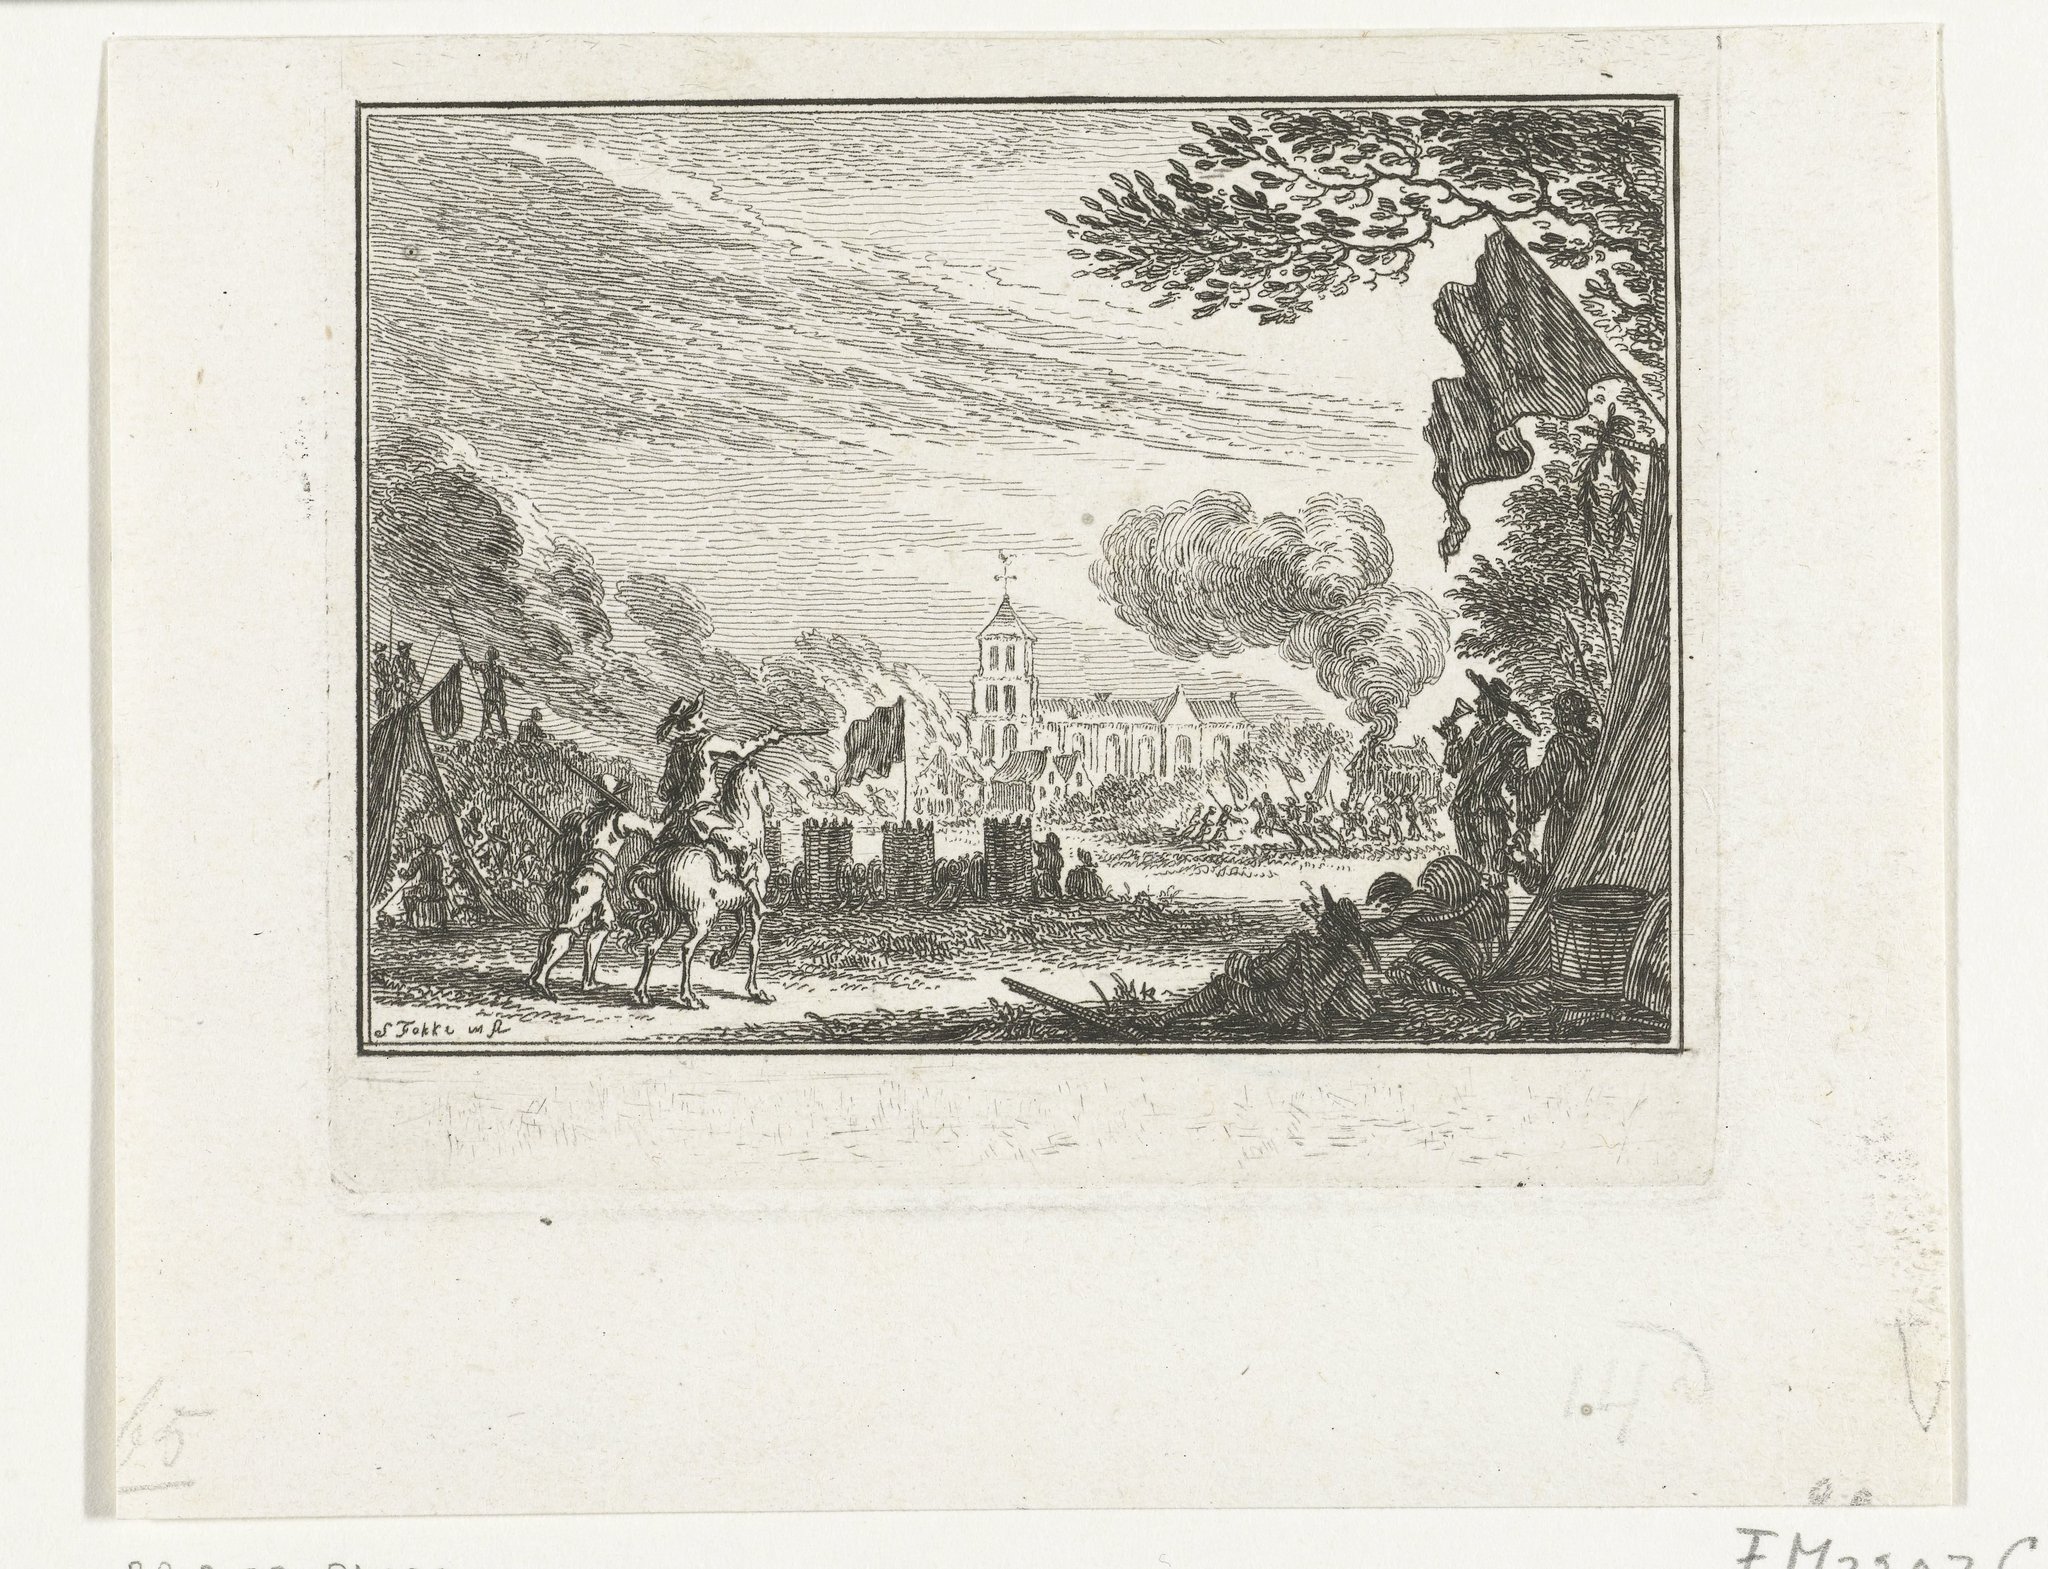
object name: history print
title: Oorlog met de bisschop van Munster, 1665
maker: simon fokke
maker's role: draughtsman, print maker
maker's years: 1712-1784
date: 1782-1784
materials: paper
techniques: etching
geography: northern netherlands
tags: battle (+ land forces)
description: Gebruikt als illustratie in: J.W. te Water, De vaderlandsche Historie van den heere J. Wagenaar, verkort, en met leerzaame aanmerkingen, ten dienste der Nederlandsche jeugd, 1784-1800, 4 delen. Dit nummer is een door het RPK toegevoegd nummer en staat niet in Frederik Muller, het werk waar de prent voor is gemaakt of uit afkomstig is, staat wel vermeld in Frederik Muller.